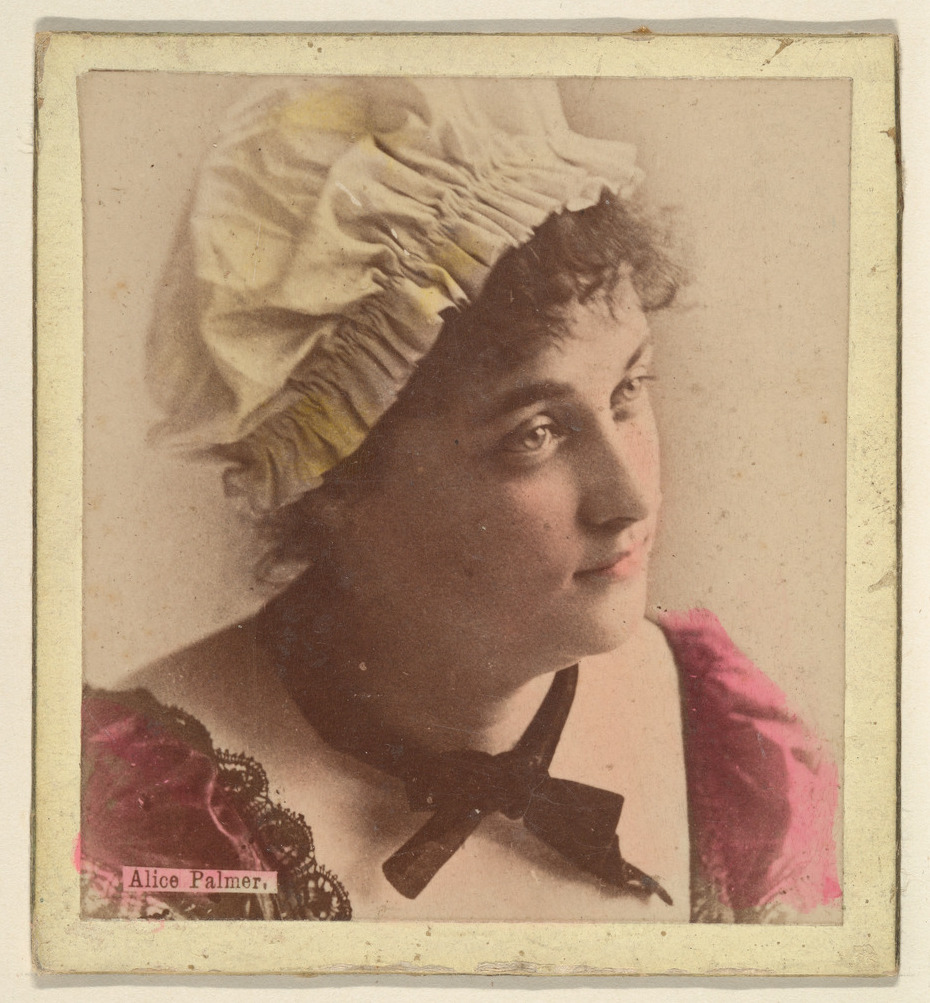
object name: photograph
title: Alice Palmer, from the Actresses series (N246), Type 2, issued by Kinney Brothers to promote Sporting Extra Cigarettes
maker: kinney brothers tobacco company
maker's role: publisher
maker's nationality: american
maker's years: 1869-2011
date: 1890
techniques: albumen silver print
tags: portraits,women,actresses